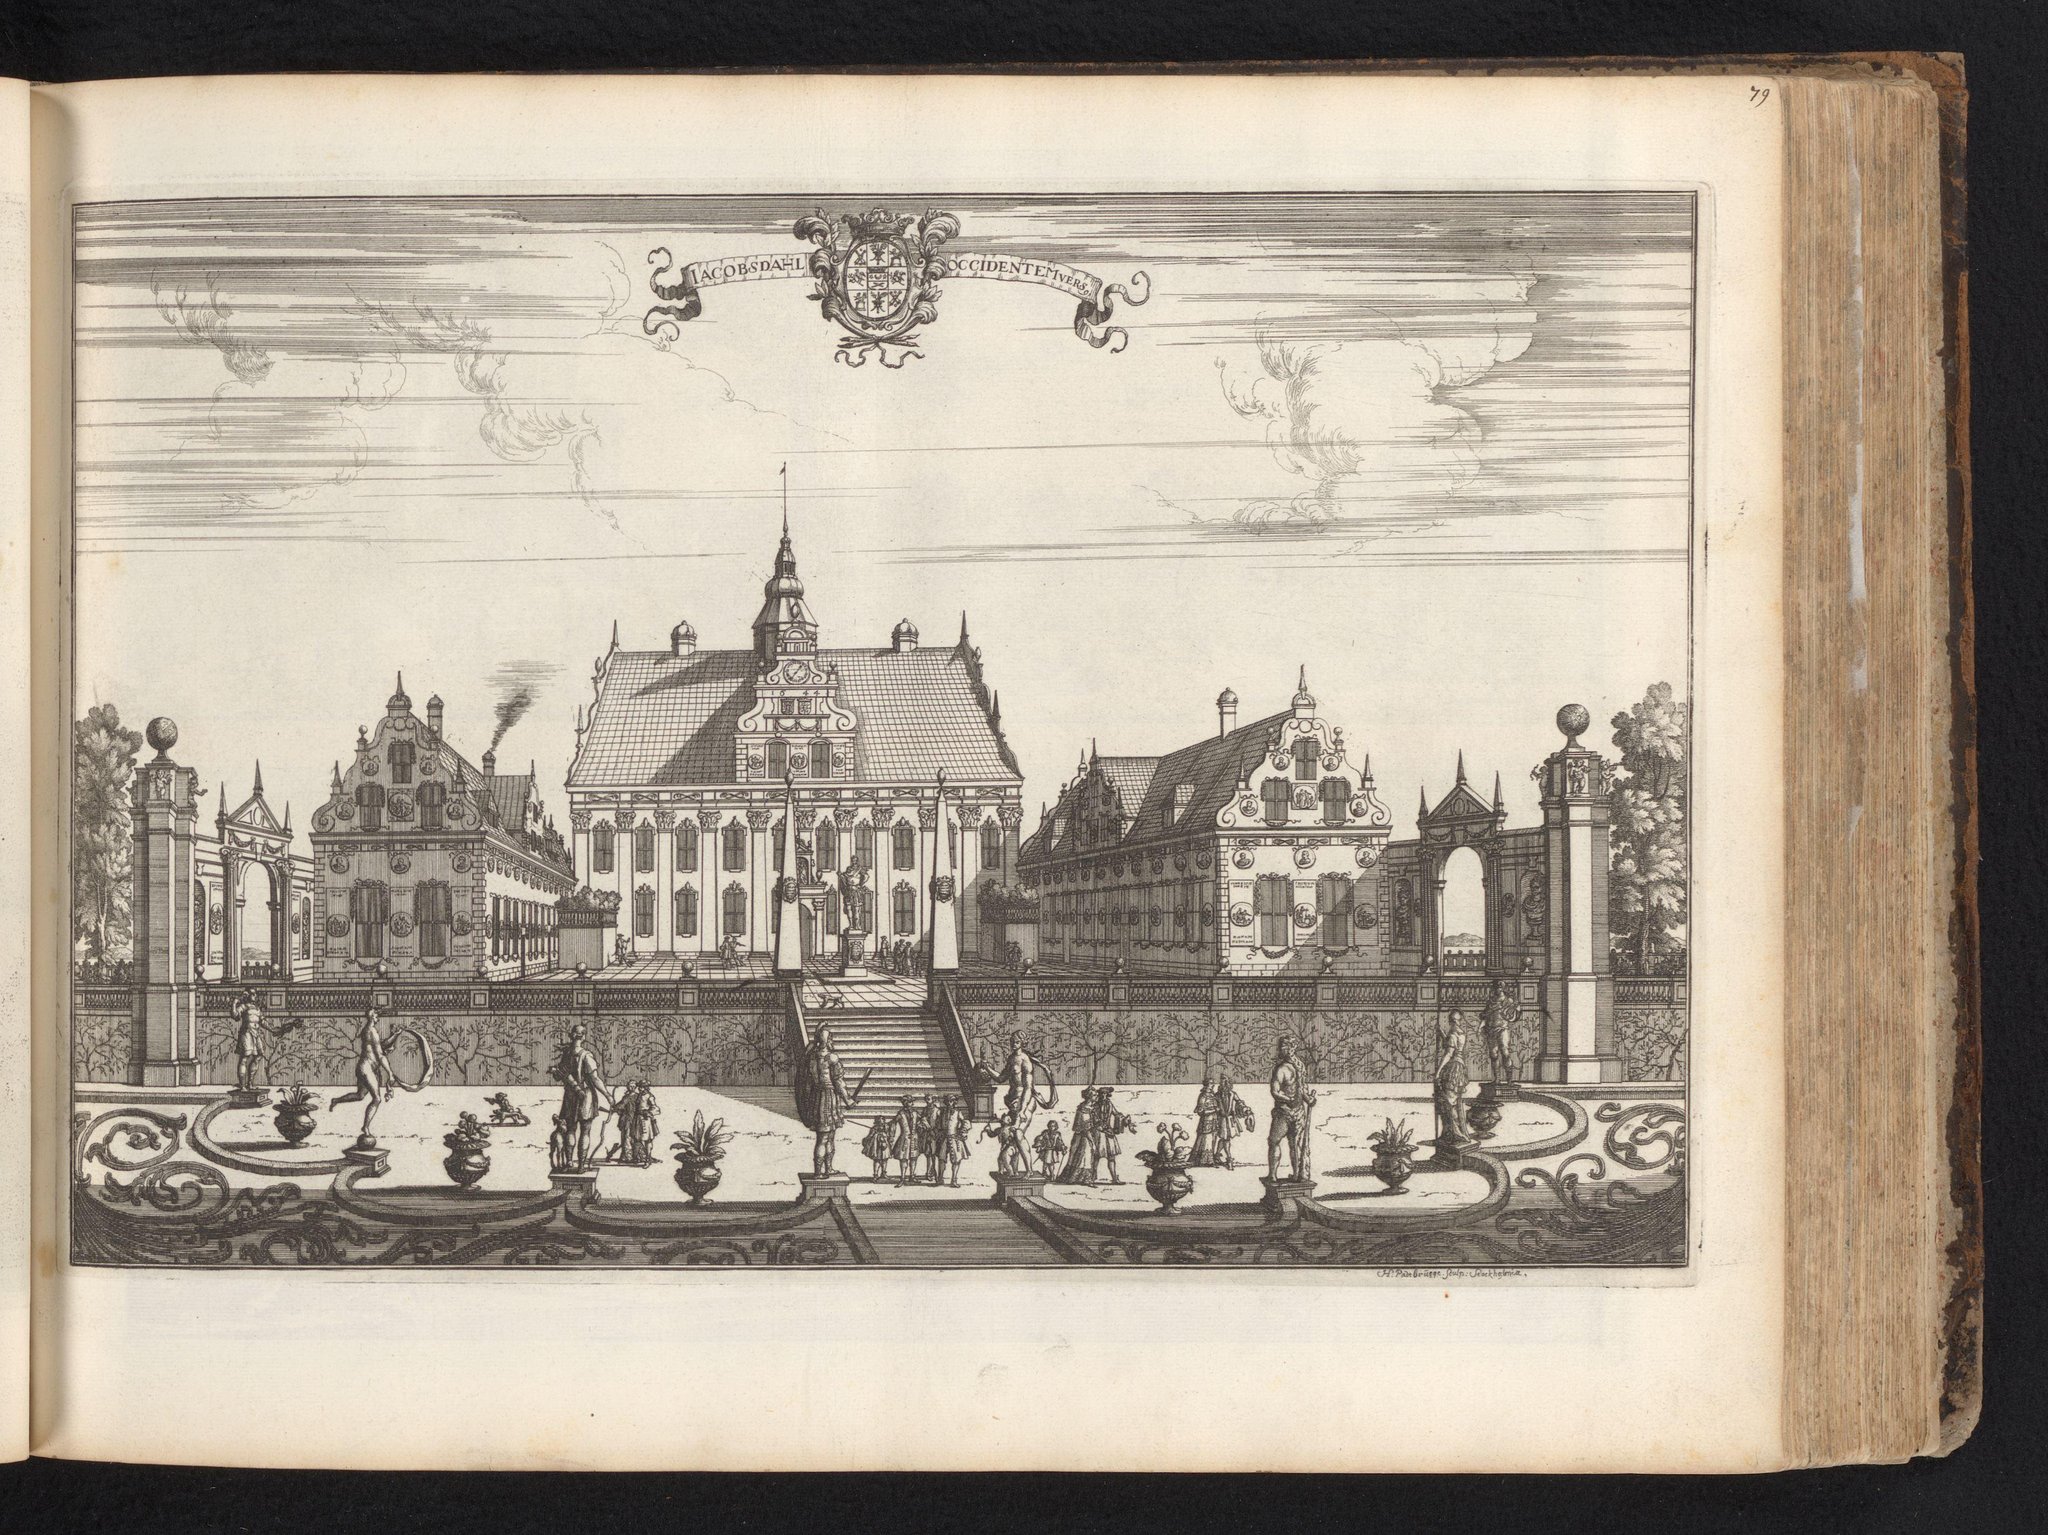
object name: print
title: Westzijde van slot Ulriksdal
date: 1686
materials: paper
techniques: etching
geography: stockholm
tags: palace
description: Kungliga Biblioteket, 'Suecia': http://www.kb.se/samlingarna/Kartor-bilder/Suecia-antiqua/ (geraadpleegd november 2016).